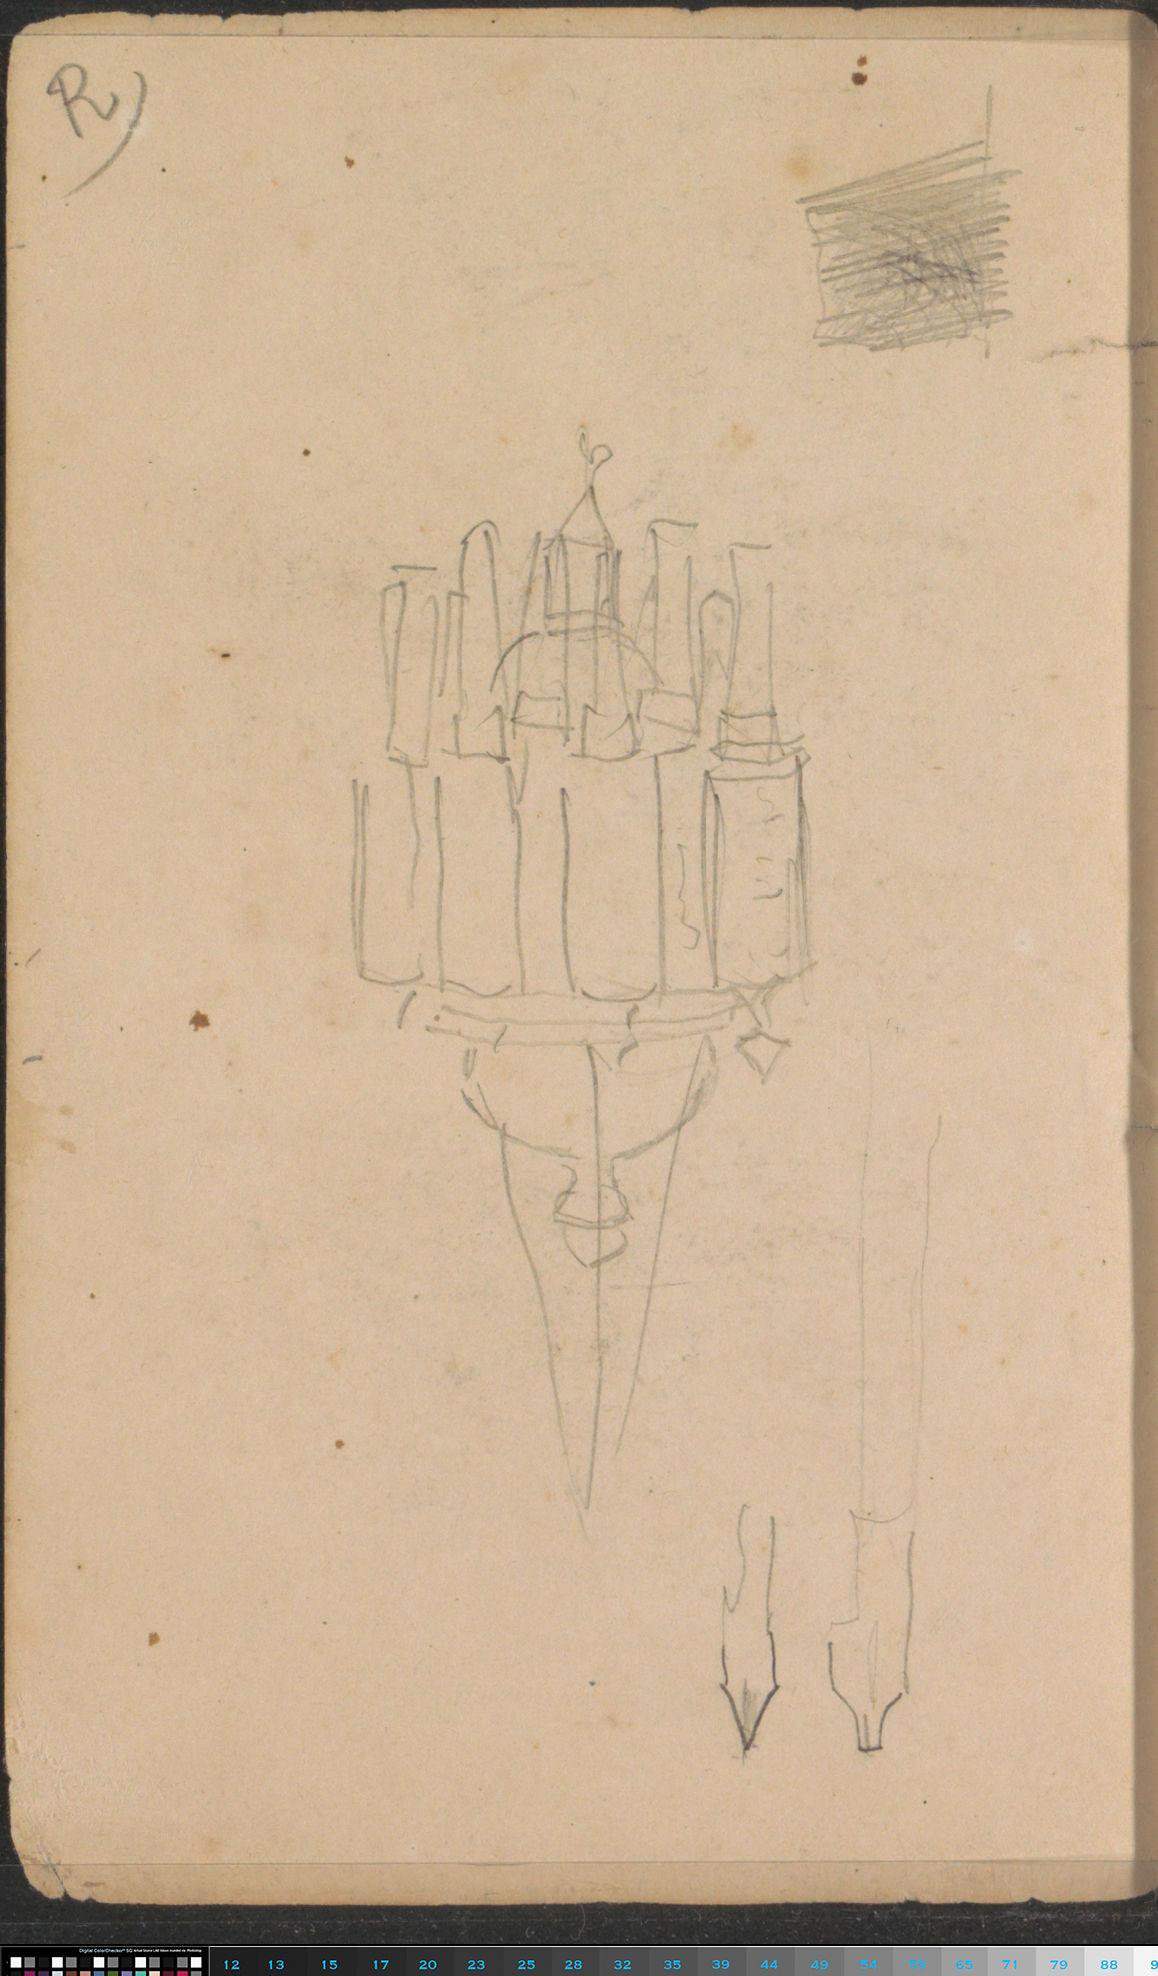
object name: sketchbook leaf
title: Torenspits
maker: marius bauer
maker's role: draughtsman, print maker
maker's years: 1867-1932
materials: paper, pencil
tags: spire (of tower on house or building)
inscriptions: annotation: ‘R)’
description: Voorste schutblad uit een schetsboek met 36 bladen.